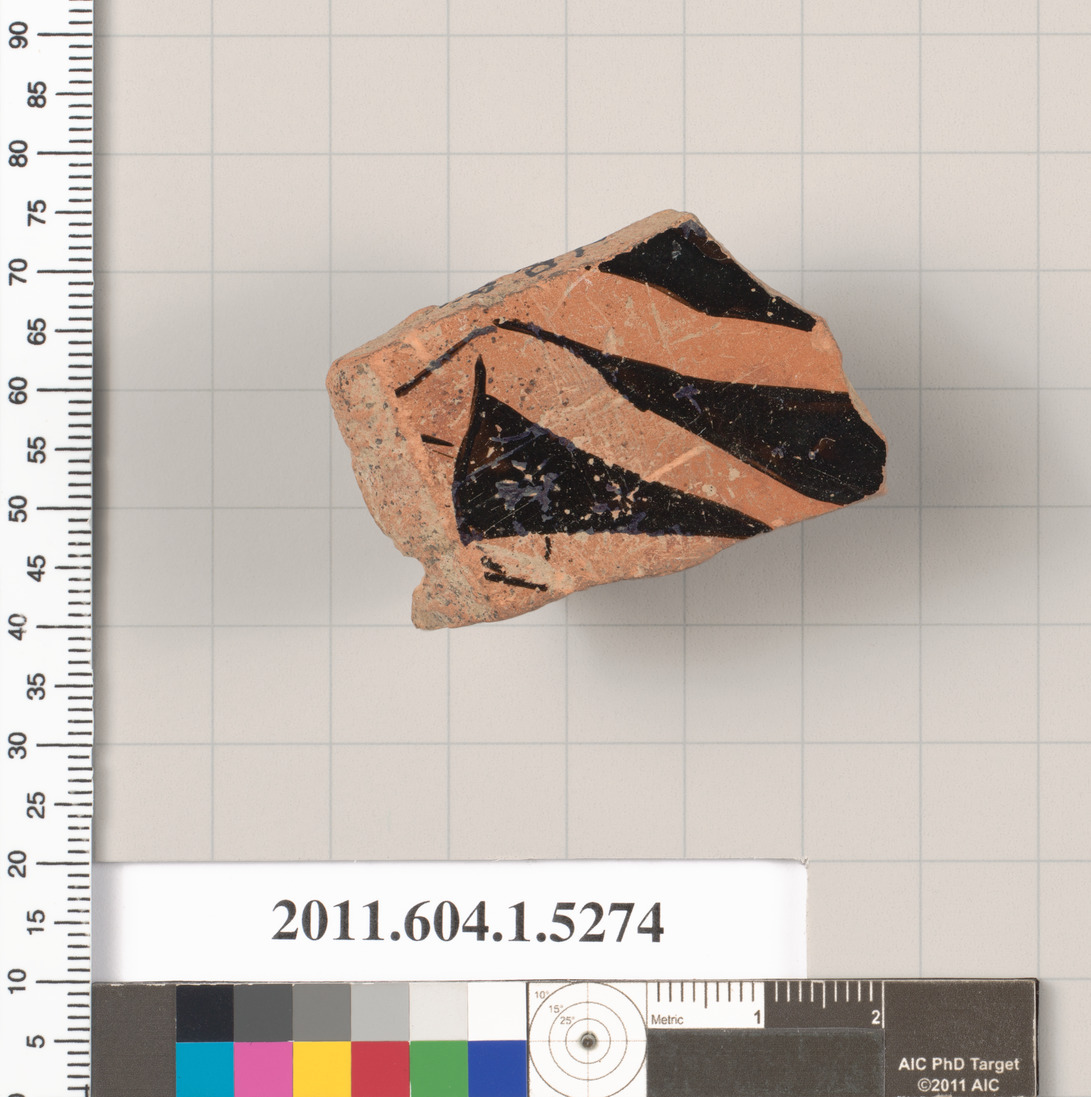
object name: kylix fragment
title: Terracotta fragment of a kylix (drinking cup)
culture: greek, attic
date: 500-480 BCE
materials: terracotta